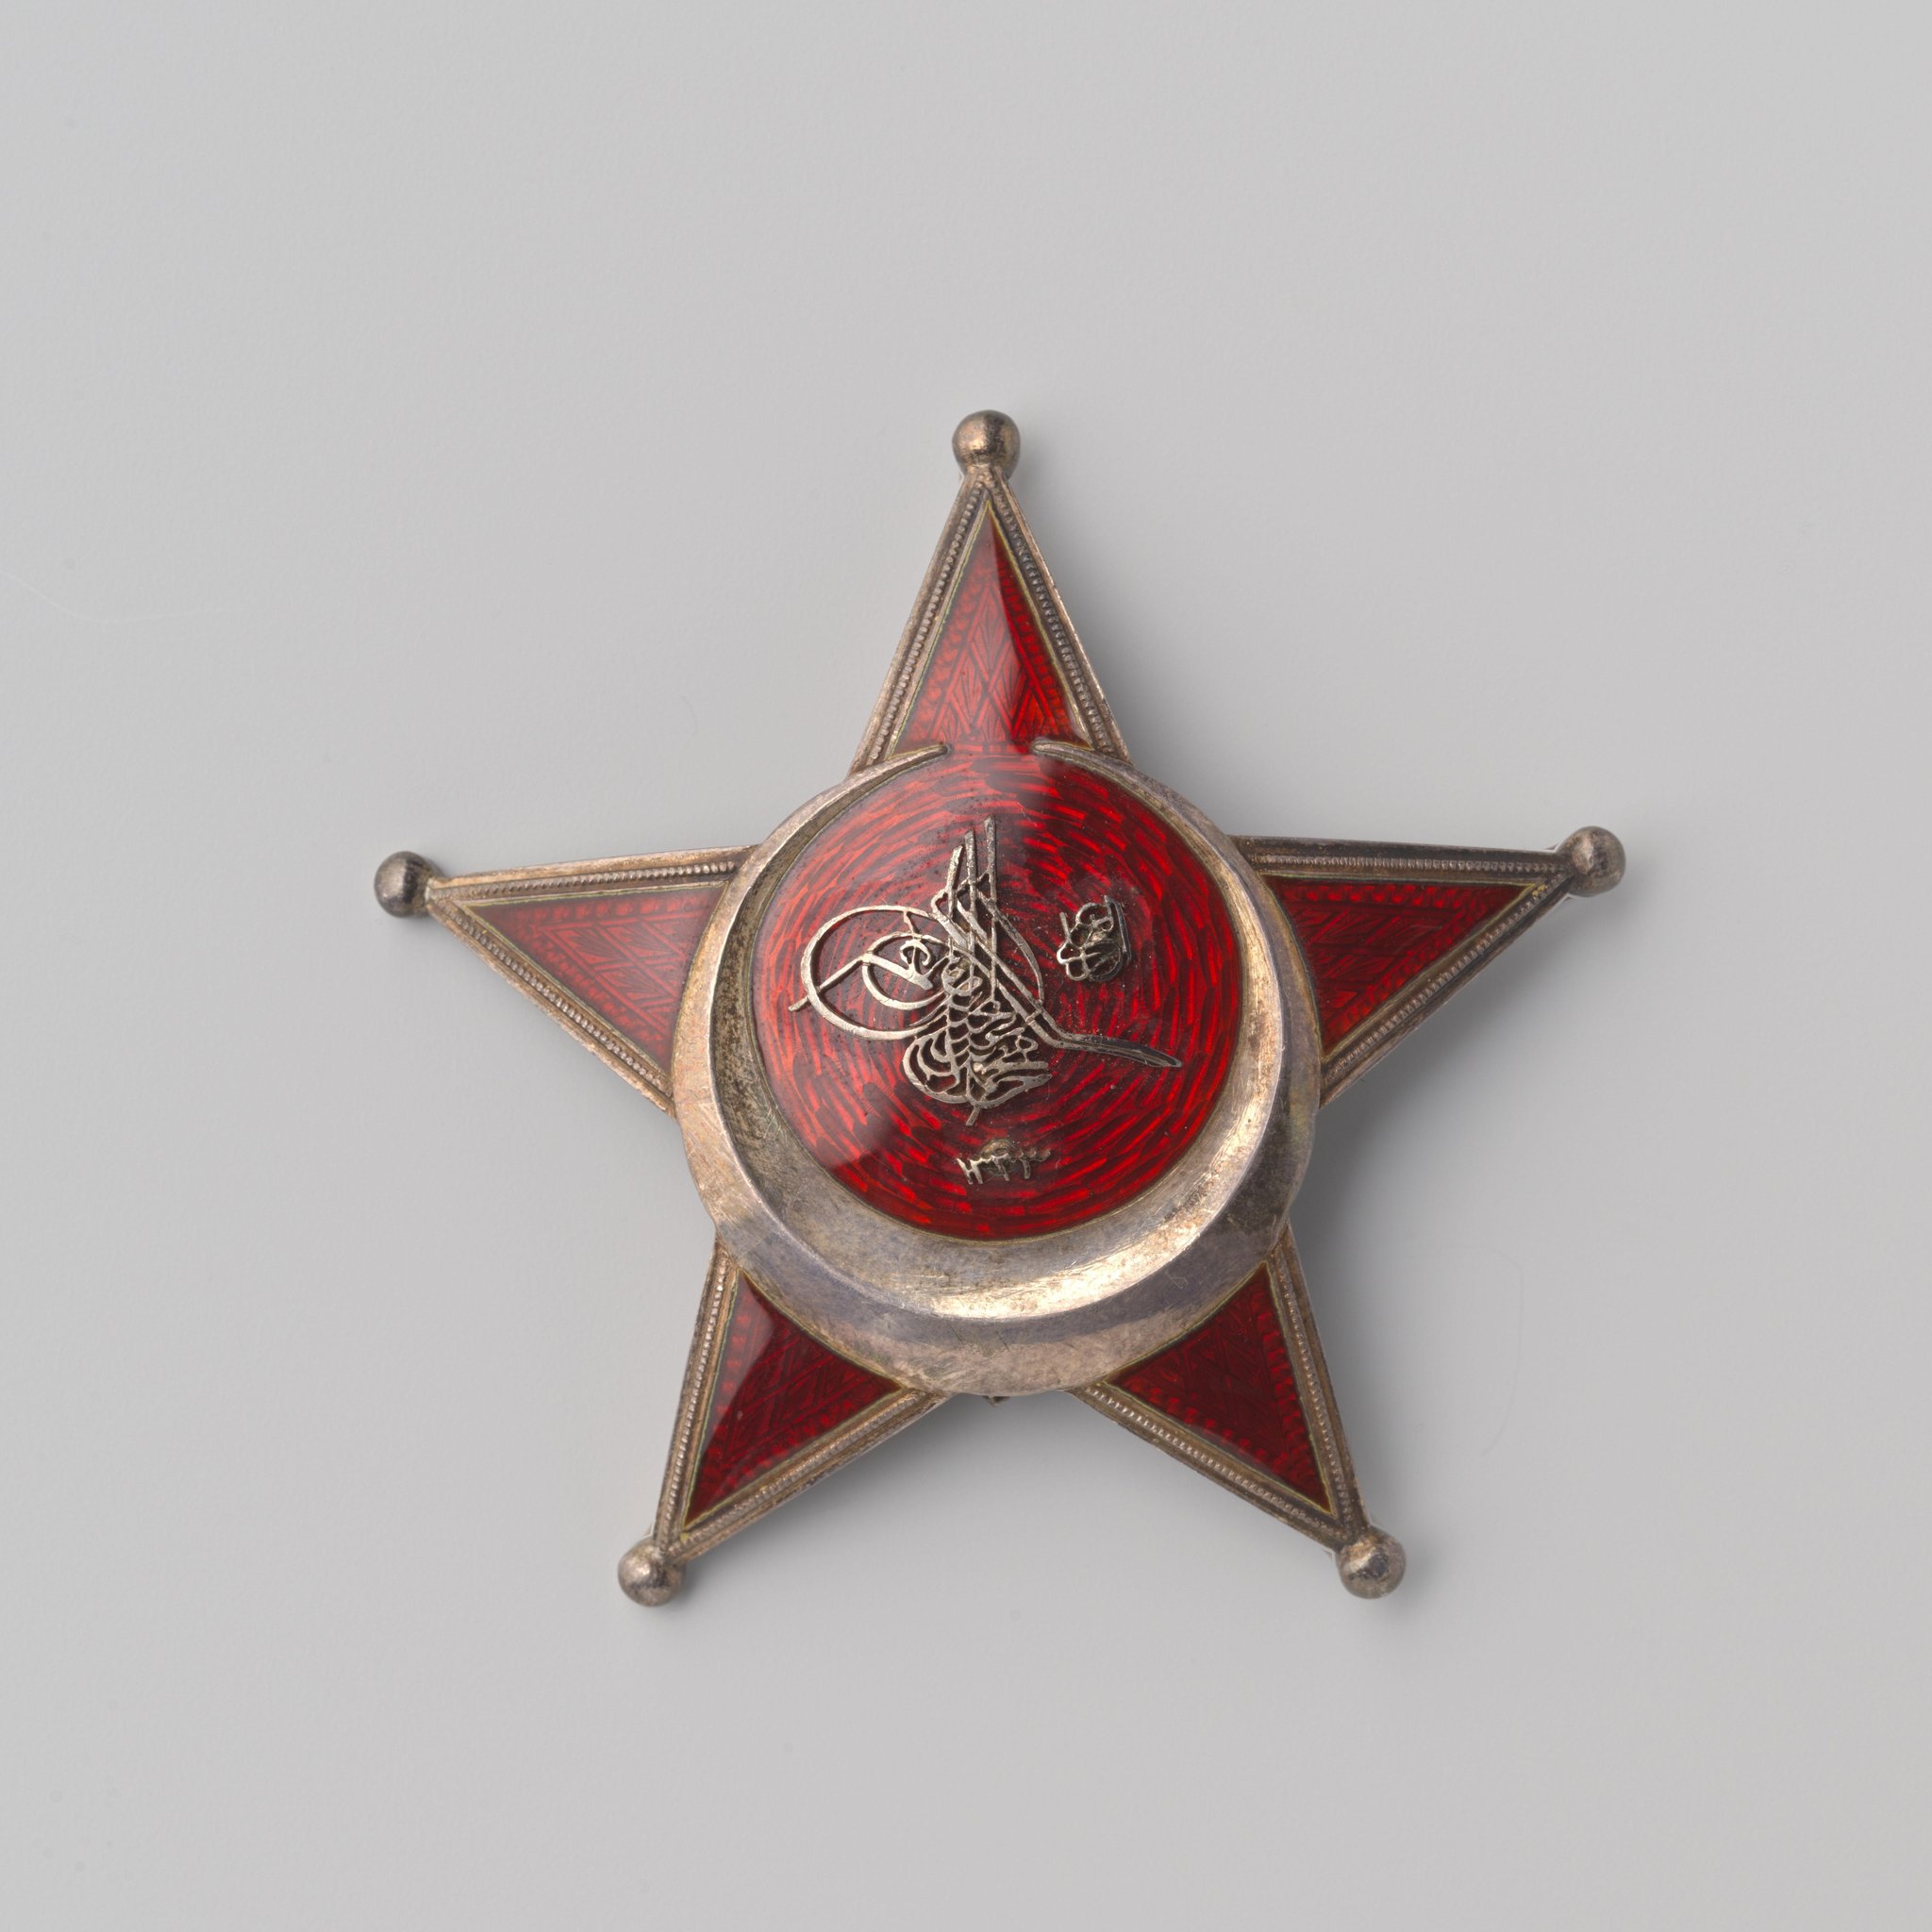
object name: onderscheidingsteken, onderscheiding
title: IJzeren halve maan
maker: Anonymous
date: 1915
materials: silver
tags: eugen wachenheimer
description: Dit object is onderdeel van de nalatenschap van Isabel Elon-Wachenheimer (1928-2010). Tot haar overlijden behoorde het samen met de andere objecten uit de nalatenschap tot haar privédomein van Isabel Wachenheimer. In die particuliere context zijn deze objecten tezamen en individueel aandenkens - aan de jeugd, ouders en familie van Isabel Wachenheimer vóór en tijdens de Shoah en aan haar leven na de Tweede Wereldoorlog. Isabel Wachenheimer, die van juni 1943 tot mei 1945 gevangen zat in Kamp Westerbork, Theresienstadt, Auschwitz, Lenzing a/d Oberdonau (een buitenkamp van Mauthausen), overleefde de Shoah. Haar ouders – Eugène Wachenheimer en Else Wachenheimer-Moos - werden op 14 oktober 1944 in Auschwitz-Birkenau vermoord.